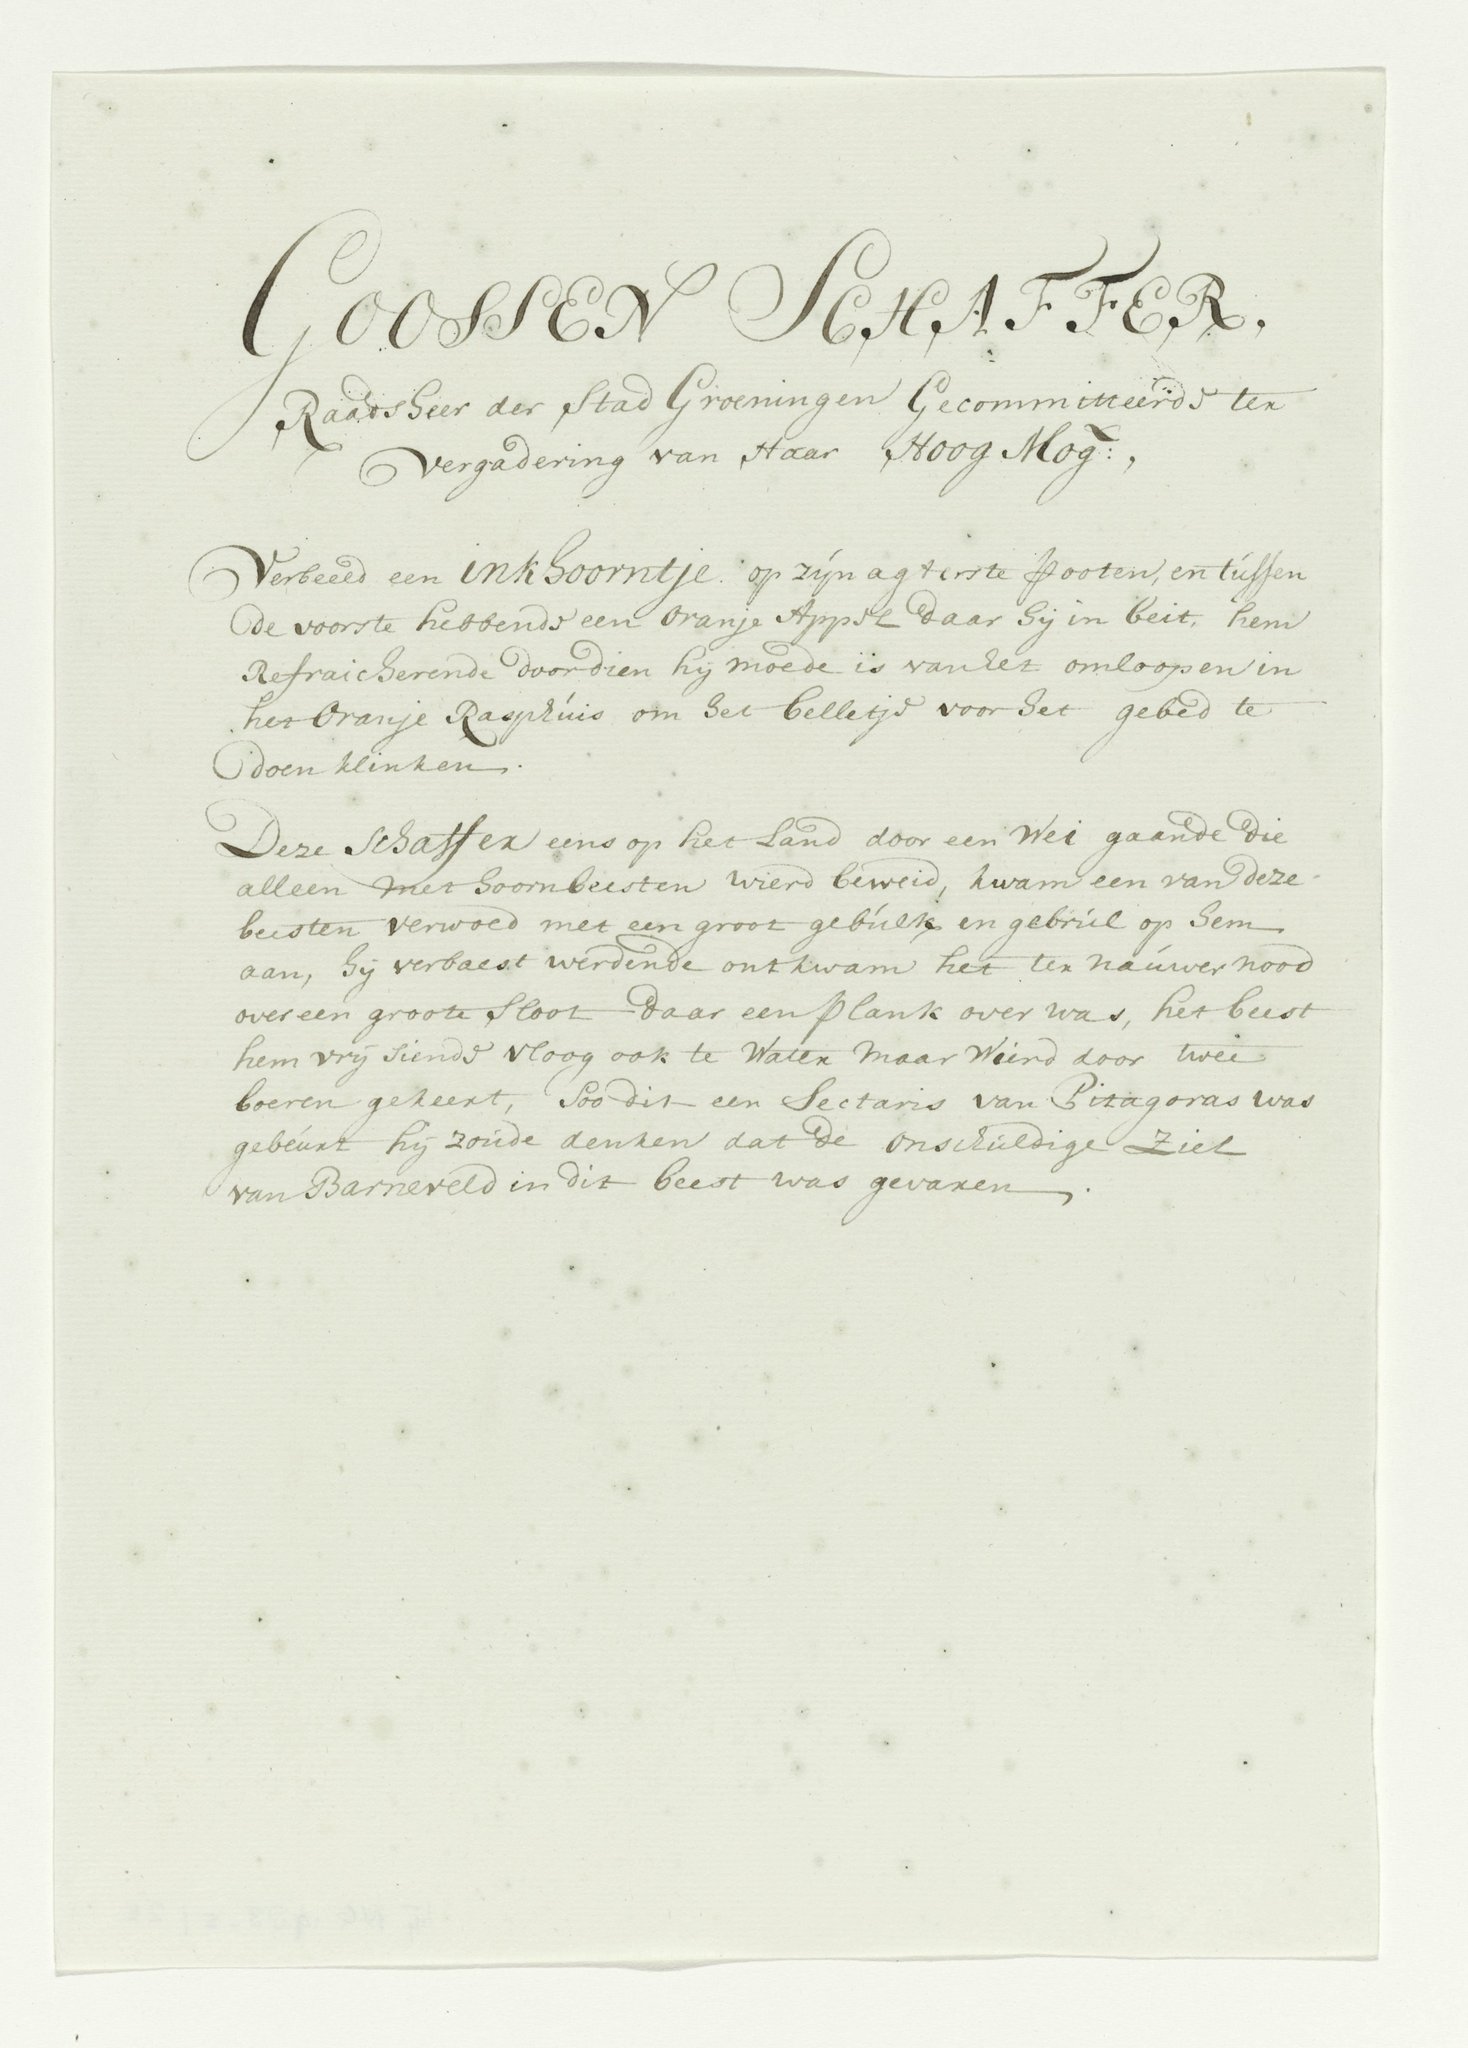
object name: manuscript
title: Regtspleging van Oldenbarnevelt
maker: Anonymous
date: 1710-1720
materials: paper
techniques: pen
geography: netherlands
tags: the hague, johan van oldenbarnevelt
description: Spotprent van Goossen Schaffer, rechter van Van Oldenbarnevelt; eekhoorn bijtend in oranje-appel. Op linkerschouder wapen. In krans van bloemen en bladeren, daaronder cartouche met naam en nummer 25. Behorende bij serie aquarellen in boek.